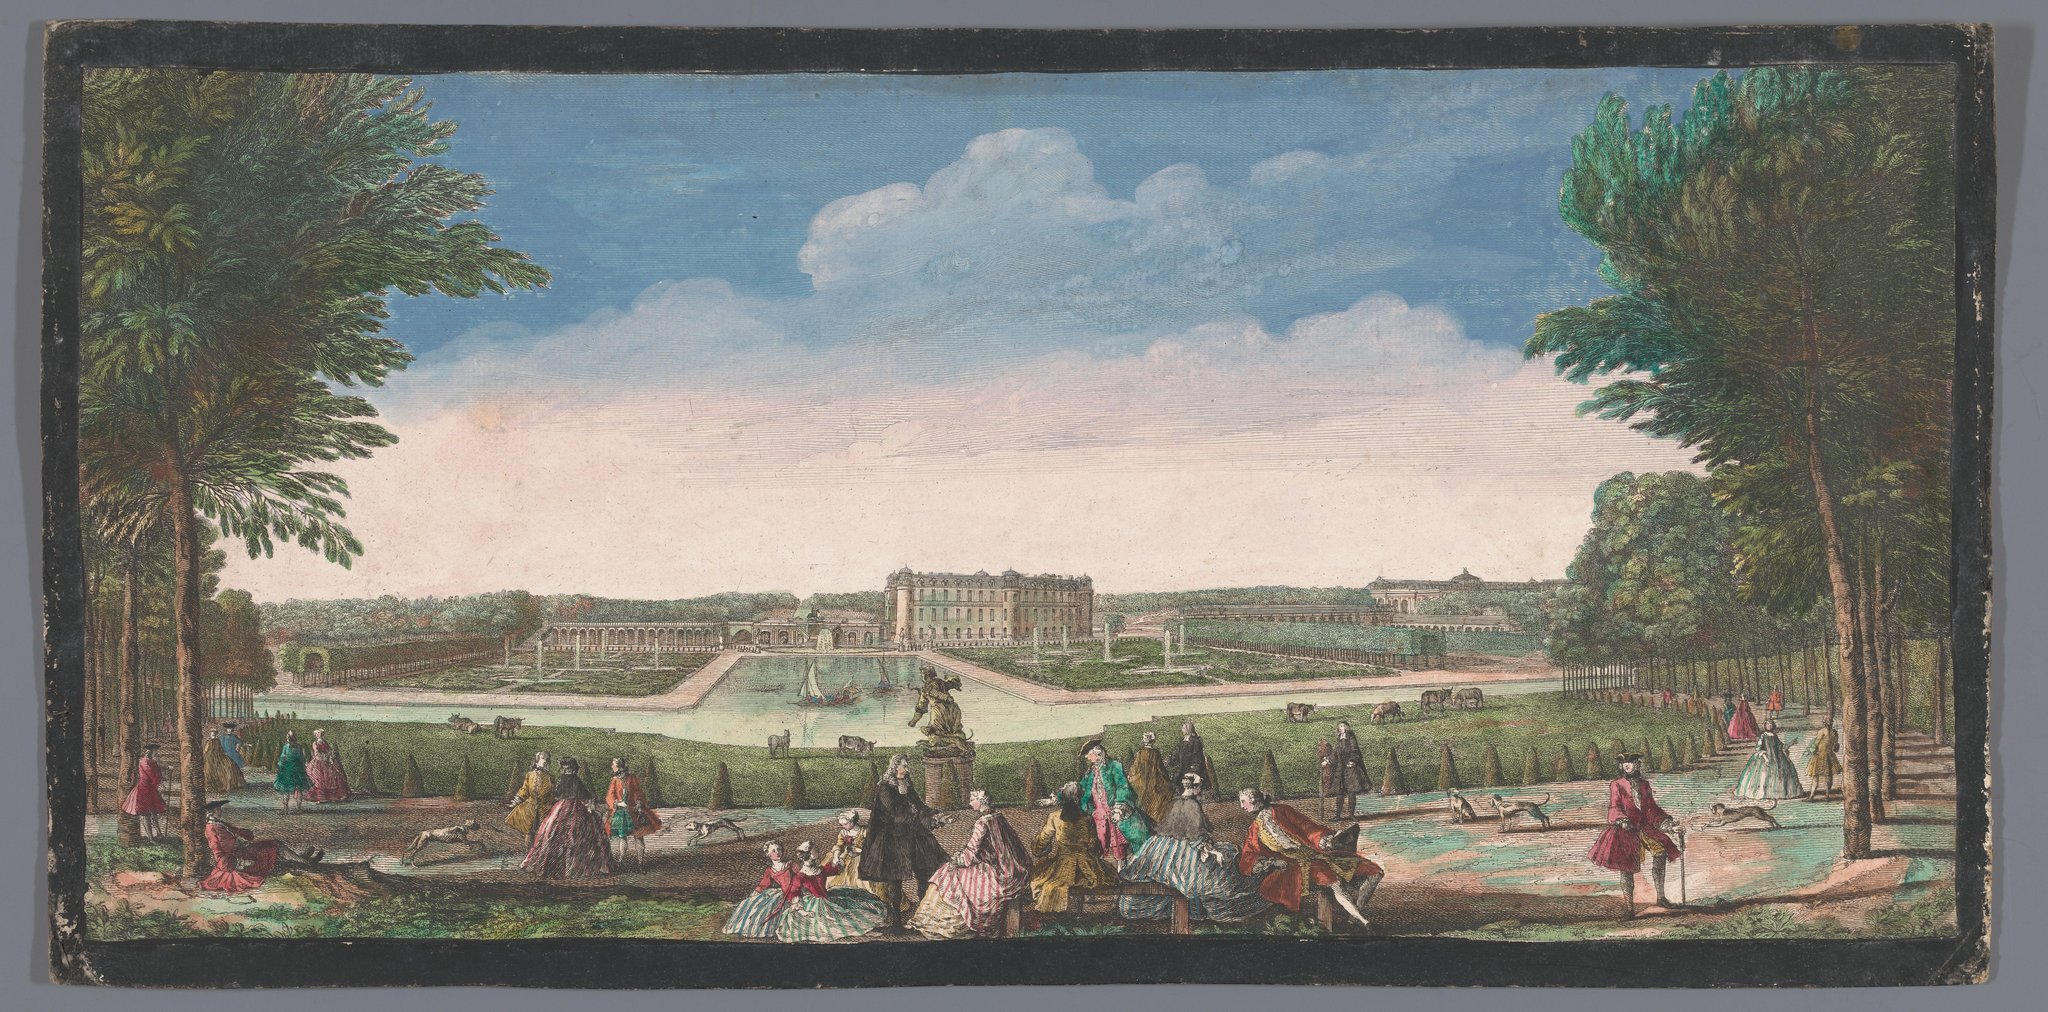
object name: opticaprent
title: Gezicht op het Grand Canal en de parterre aan het water van de tuin van het Château de Chantilly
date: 1700-1799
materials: cardboard, paper, watercolor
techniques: brush, etching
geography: paris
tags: garden, garden fountain, ornamental plants, garden ornaments, water-works in garden, civic architecture; edifices; dwellings